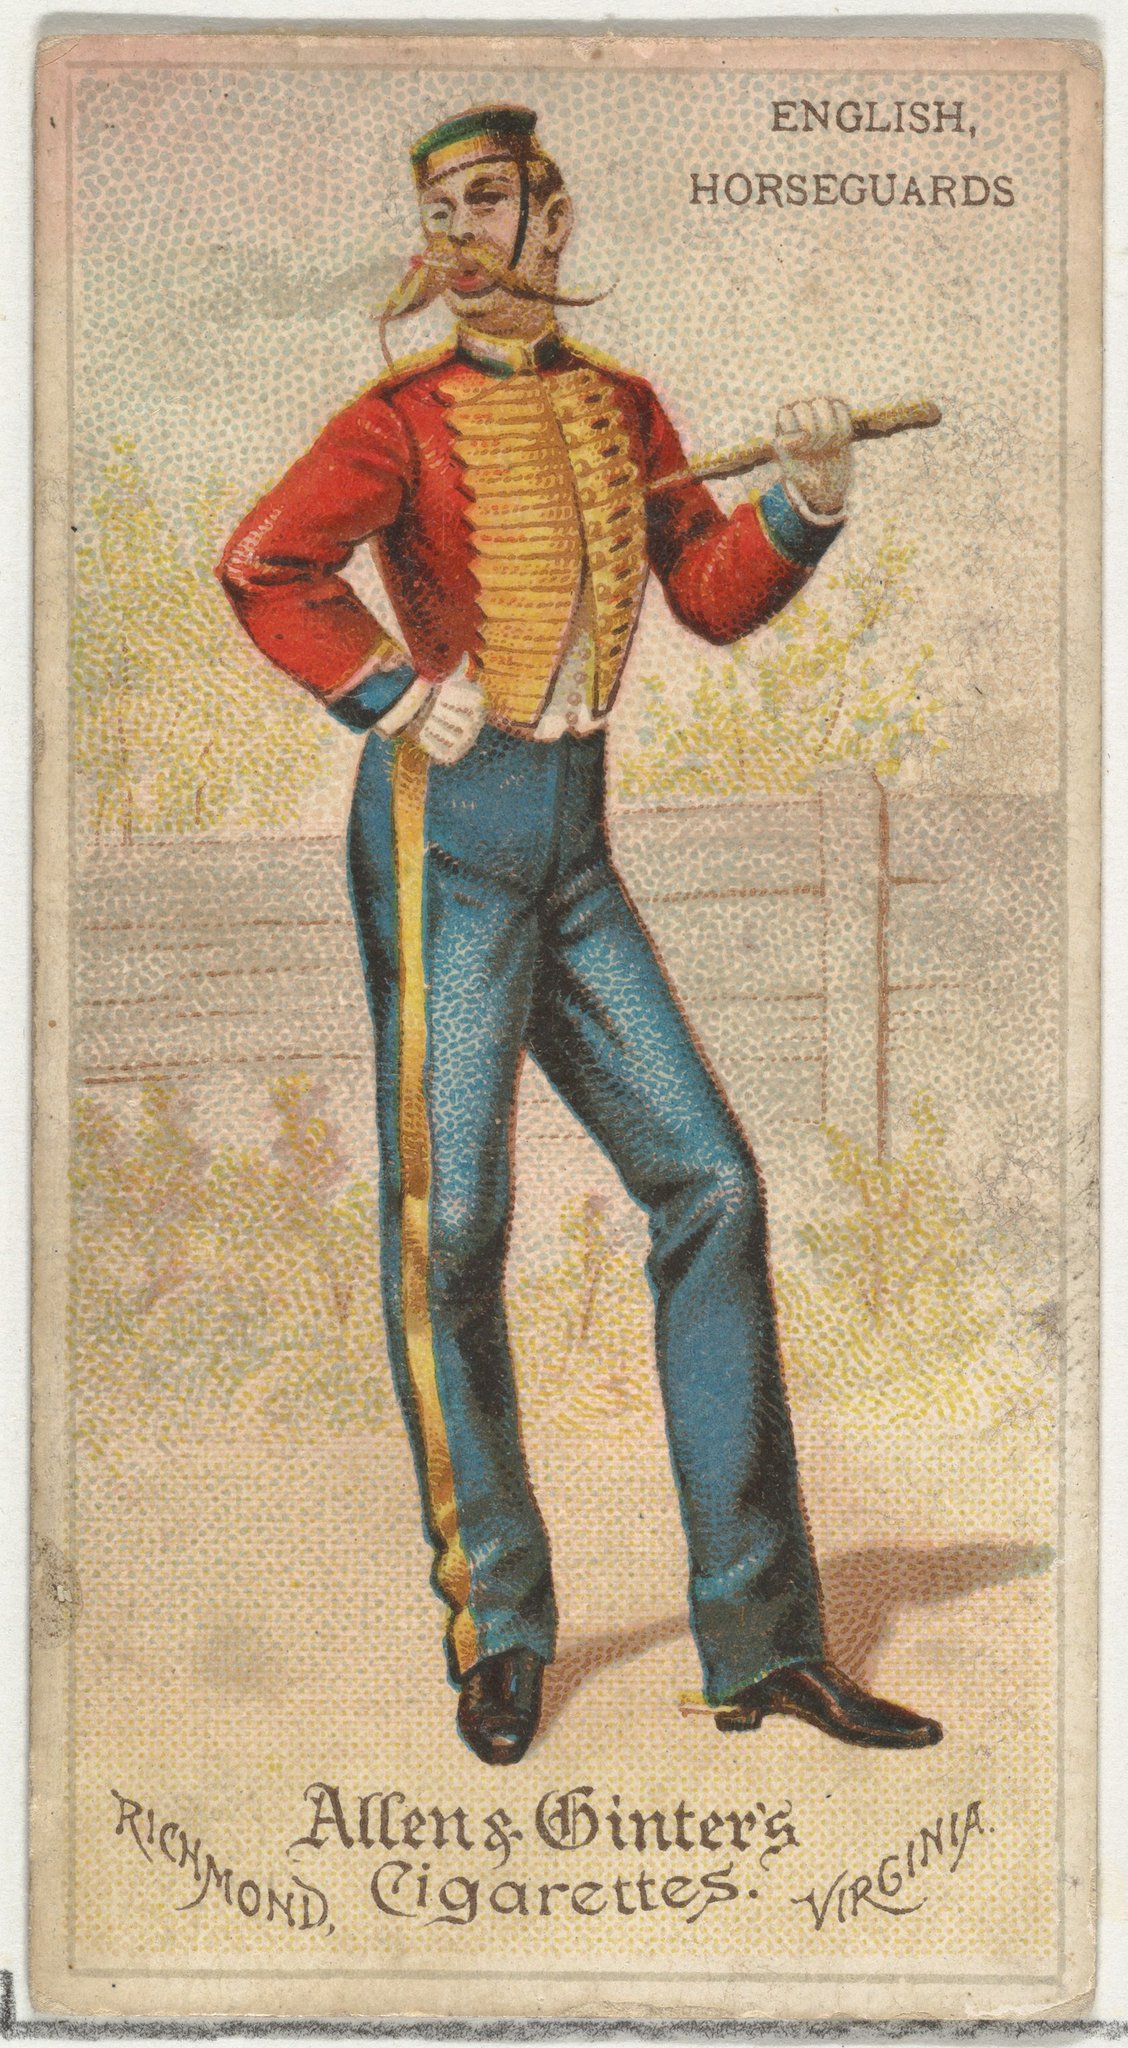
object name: print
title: English Horseguards, from World's Dudes series (N31) for Allen & Ginter Cigarettes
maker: allen & ginter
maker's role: publisher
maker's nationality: american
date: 1888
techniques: color lithograph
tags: men